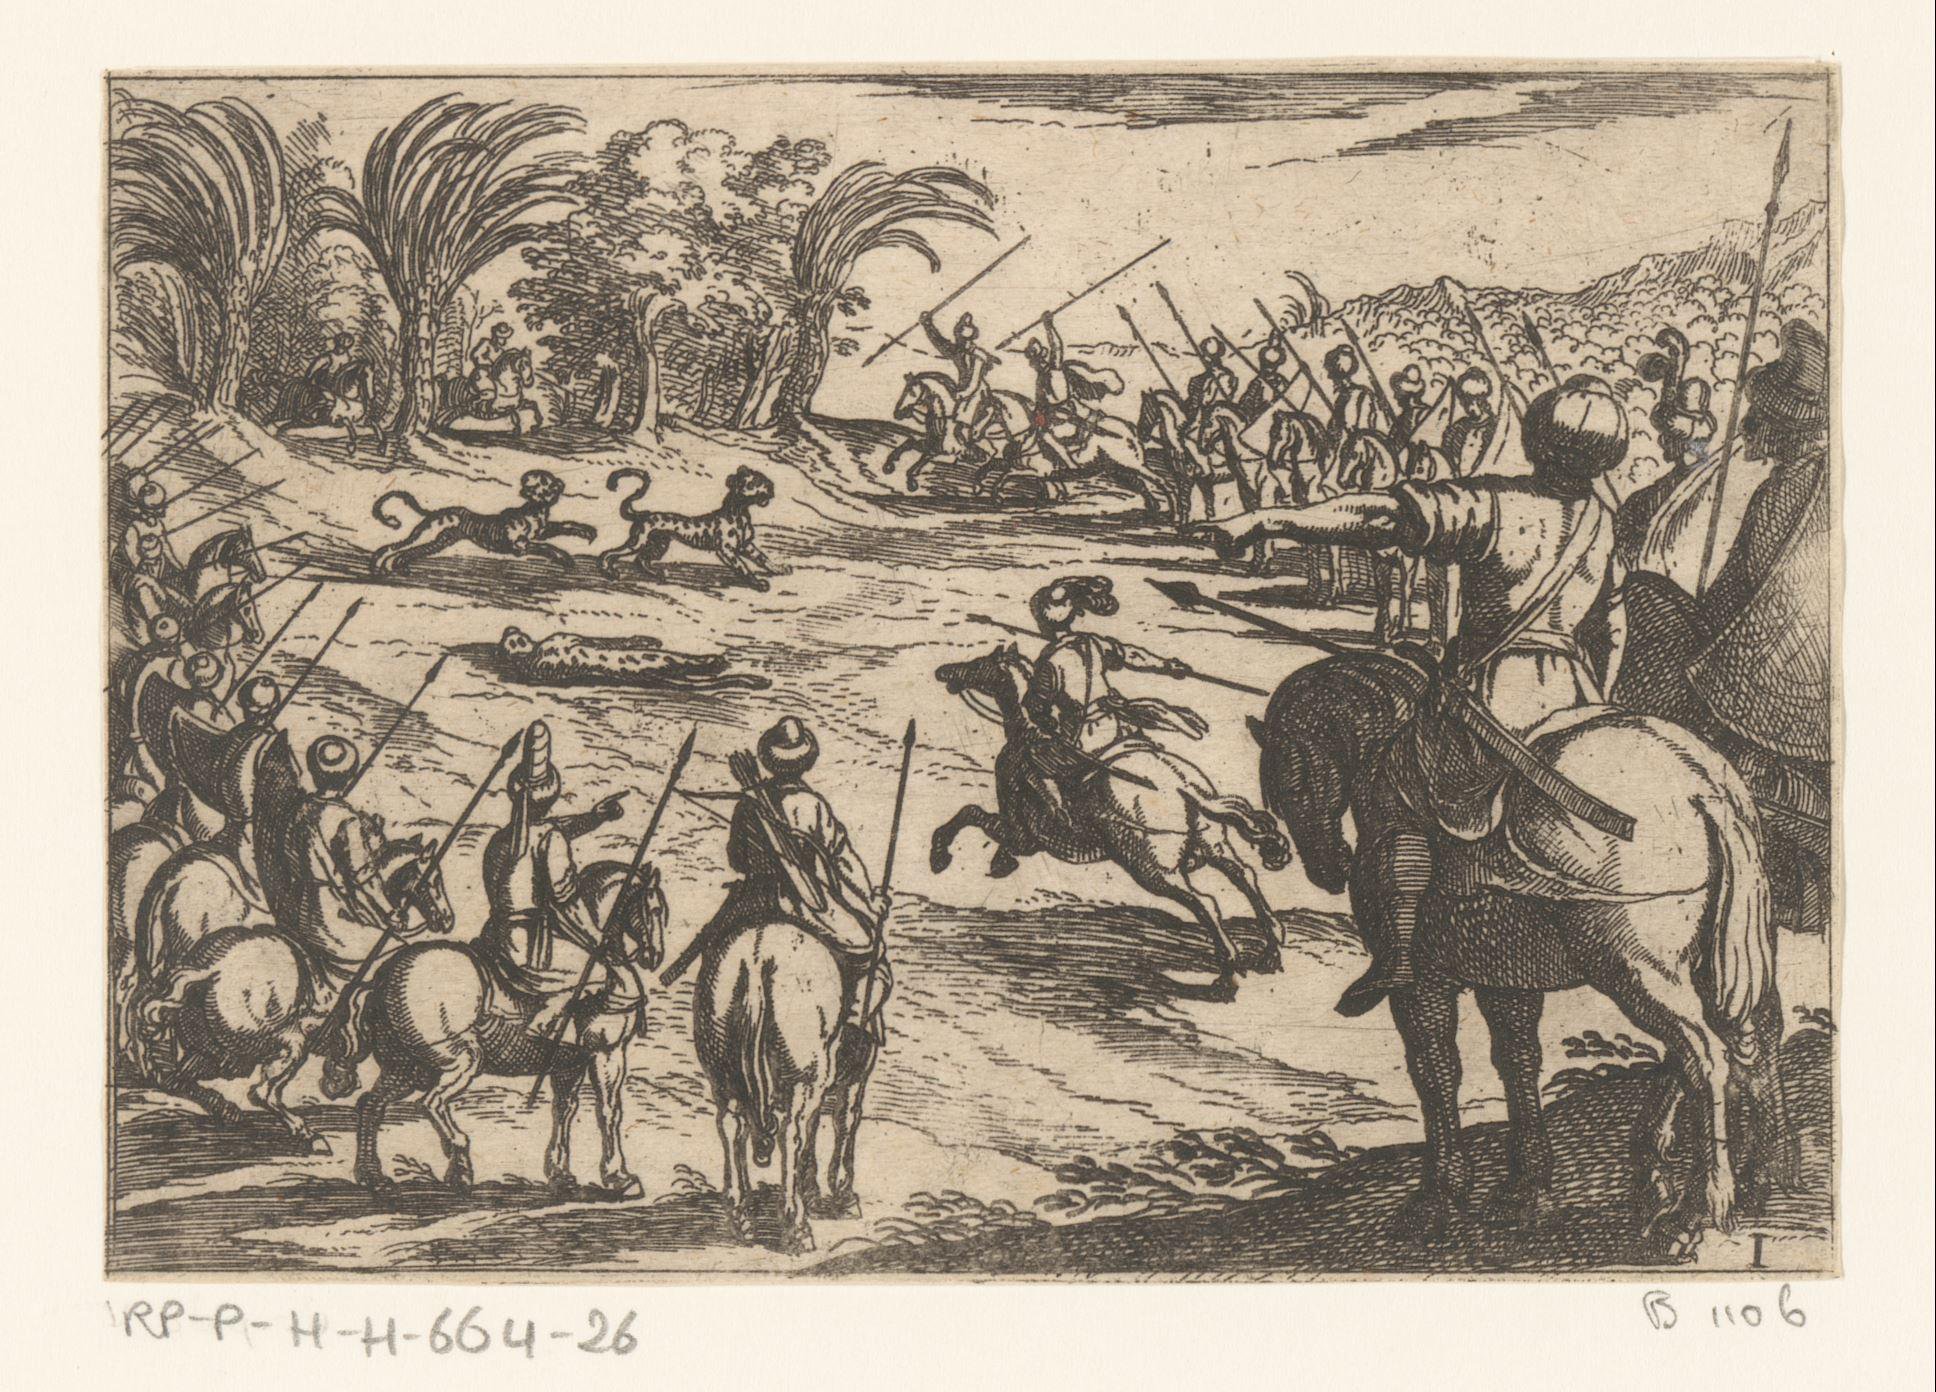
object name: print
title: Jachtscènes (deel 3)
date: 1598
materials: paper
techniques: etching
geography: italy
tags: beasts of prey, predatory animals: tiger, beasts of prey, predatory animals: leopard, hunter, hunters hunting (n.b.: in 1988-1990 this notation denoted the concept of 43c11421 'hunters resting during the hunt')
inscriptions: collector's mark: ‘Hinloopen’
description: Deze prent maakt deel uit van een reeks van vijftien prenten met jachtscènes (+ opdracht).